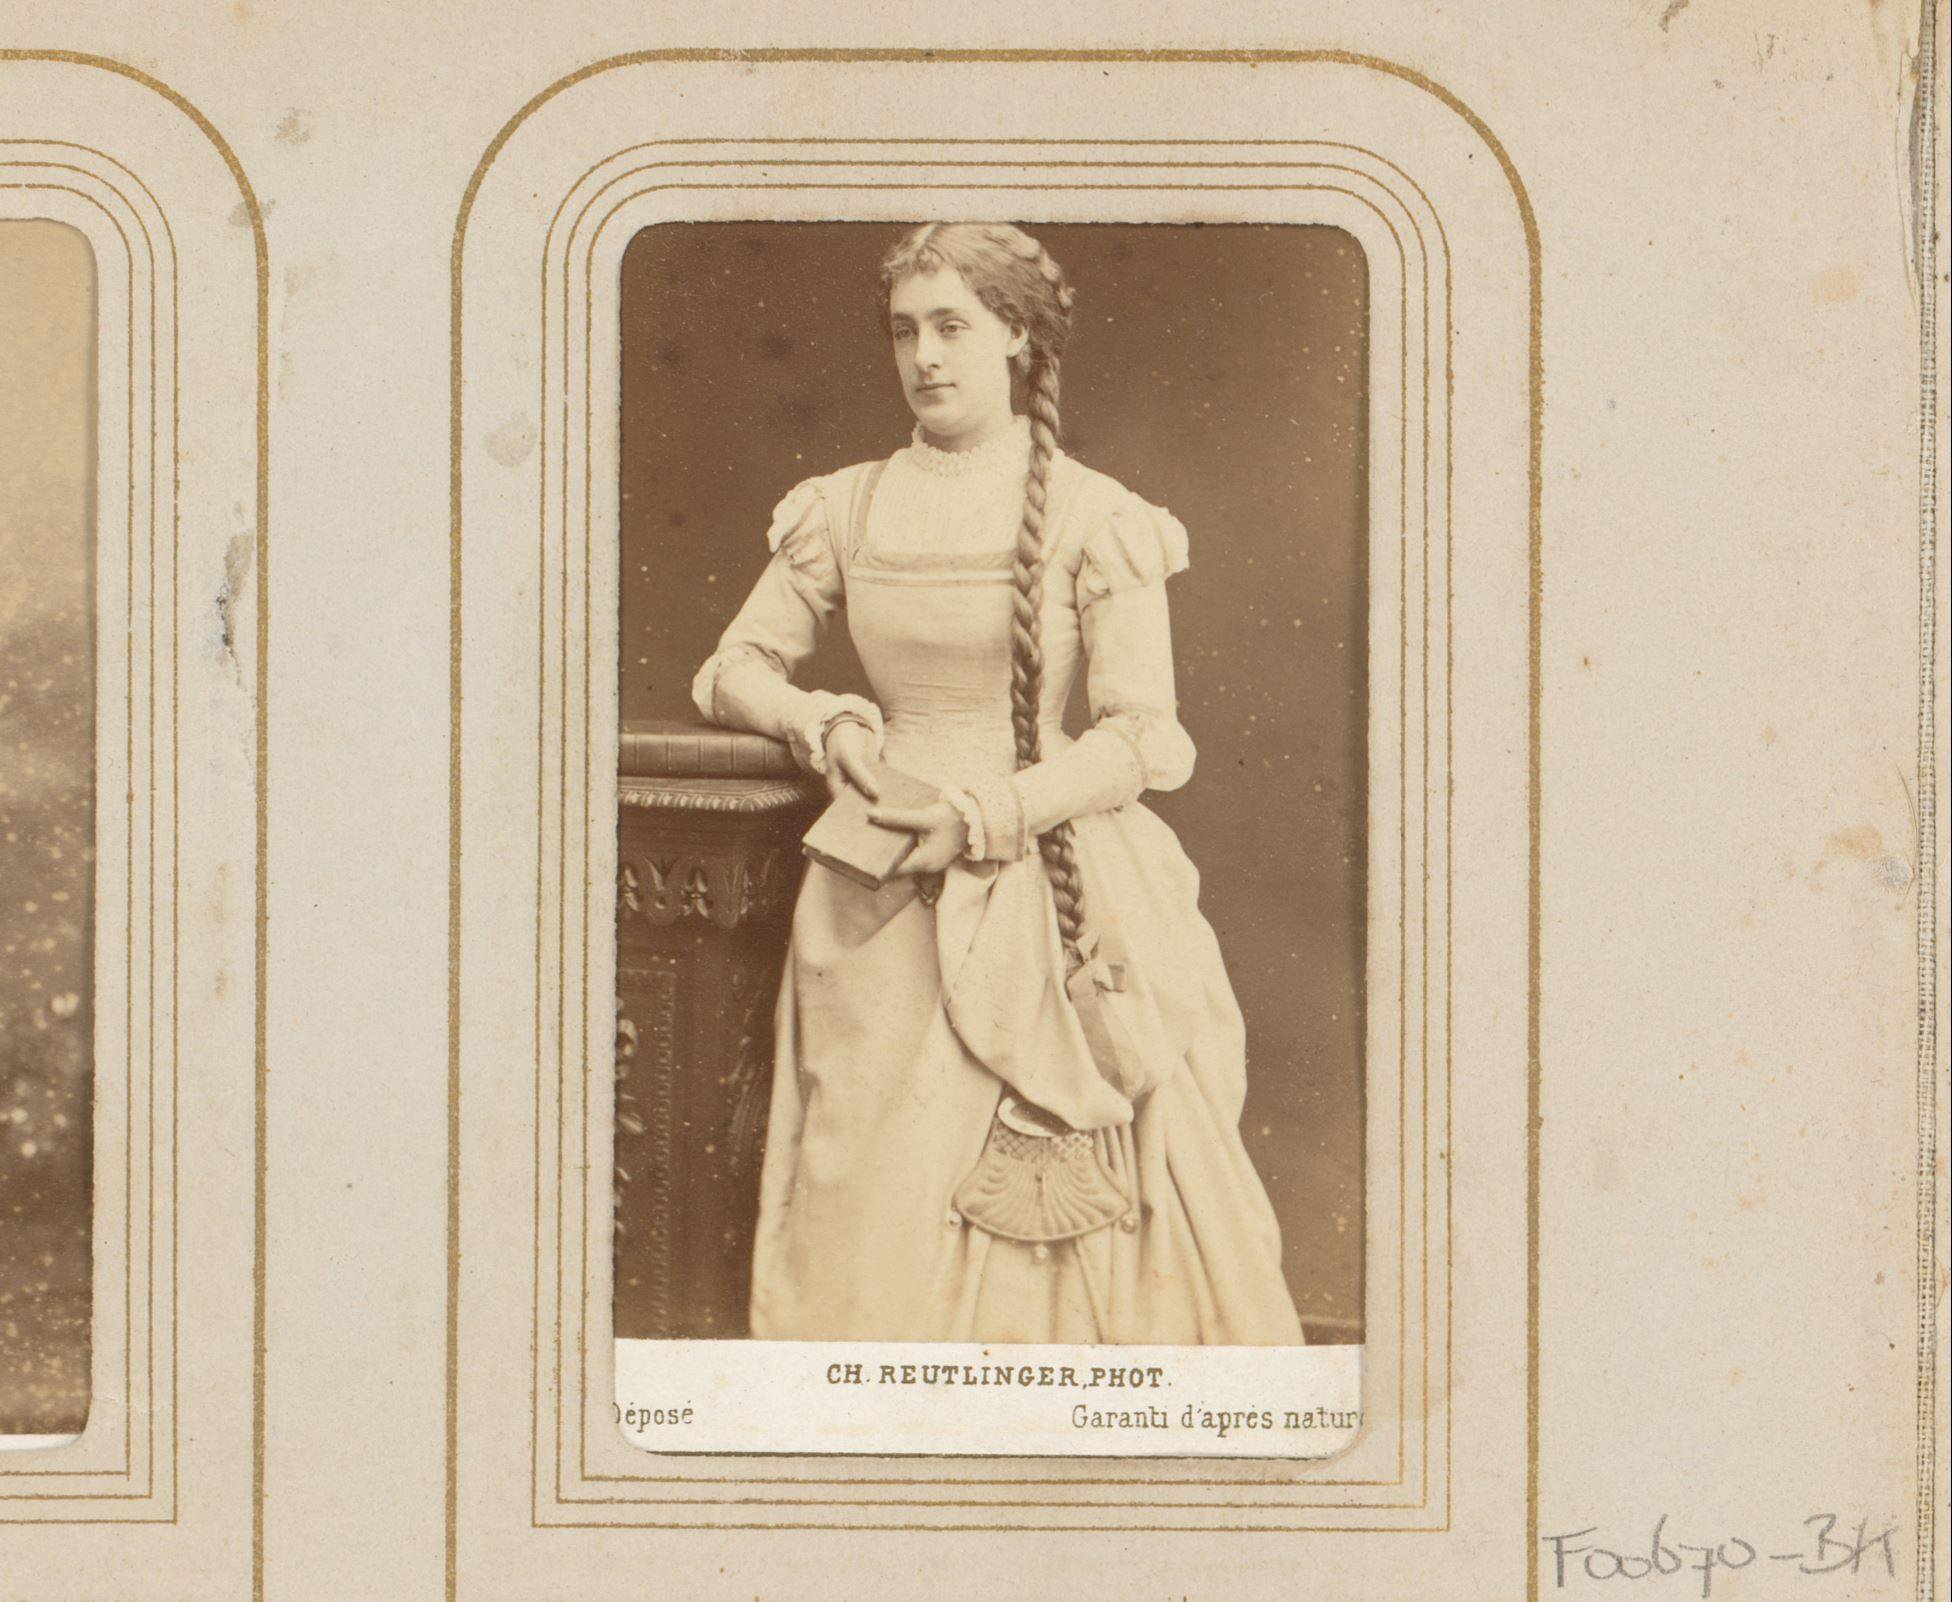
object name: carte de visite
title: Portret van Fidès Devries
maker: charles reutlinger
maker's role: publisher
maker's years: 1816-1880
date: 1870-1880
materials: cardboard, photographic support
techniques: albumen print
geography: paris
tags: historical persons - bb - woman, female singer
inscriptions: inscription: ‘(...) Ch. Reutlinger/ Photographe/ 21, Boulevard Montmartre, 21/ Paris’, annotation: ‘[...]’, annotation: ‘Fides de Vries (Reutlinger’